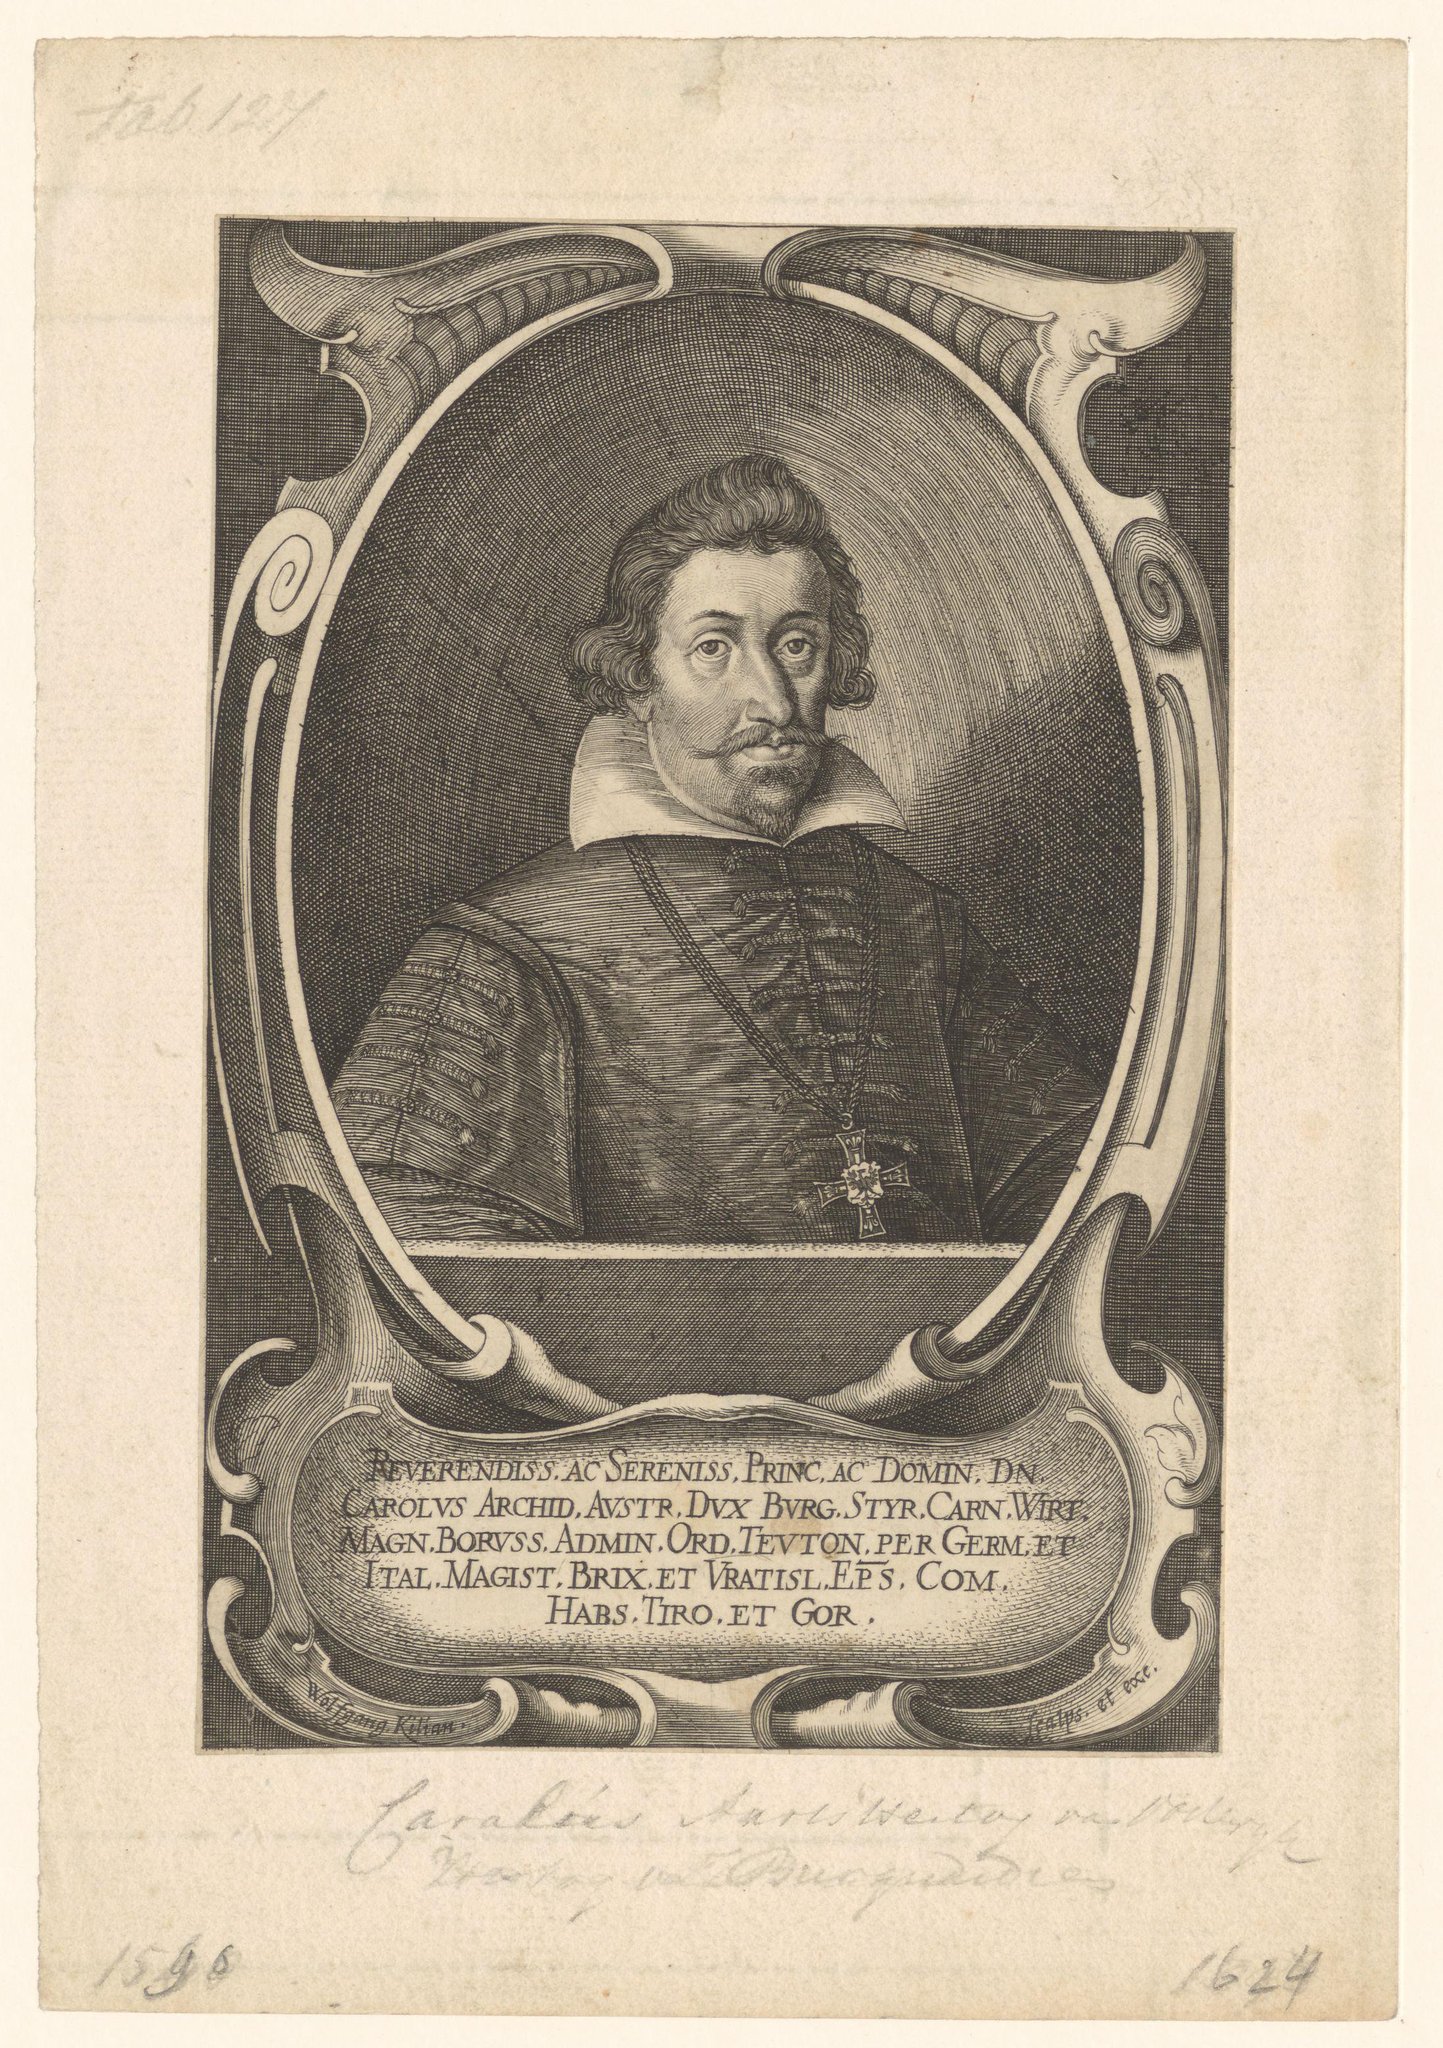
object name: print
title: Portret van Karel van Oostenrijk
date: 1617-1662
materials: paper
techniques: engraving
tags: knighthood order (red eagle order), historical persons, ruler, sovereign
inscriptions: collector's mark: Lugt 2228